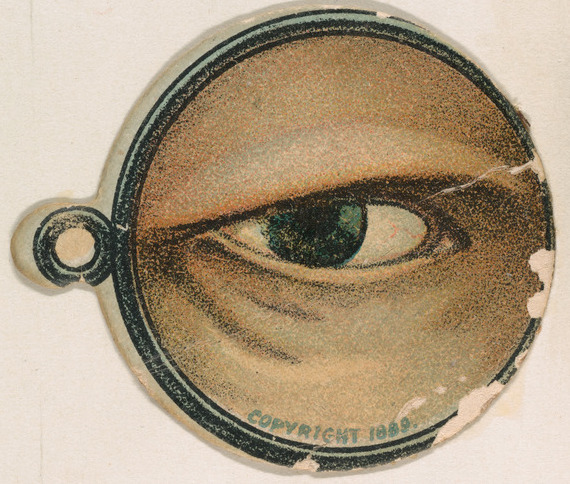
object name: print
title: Monocle and Eye (dark blue), from Jocular Ocular series (N221) issued by Kinney Bros.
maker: kinney brothers tobacco company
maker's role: publisher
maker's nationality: american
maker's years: 1869-2011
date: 1889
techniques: color lithograph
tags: eyes